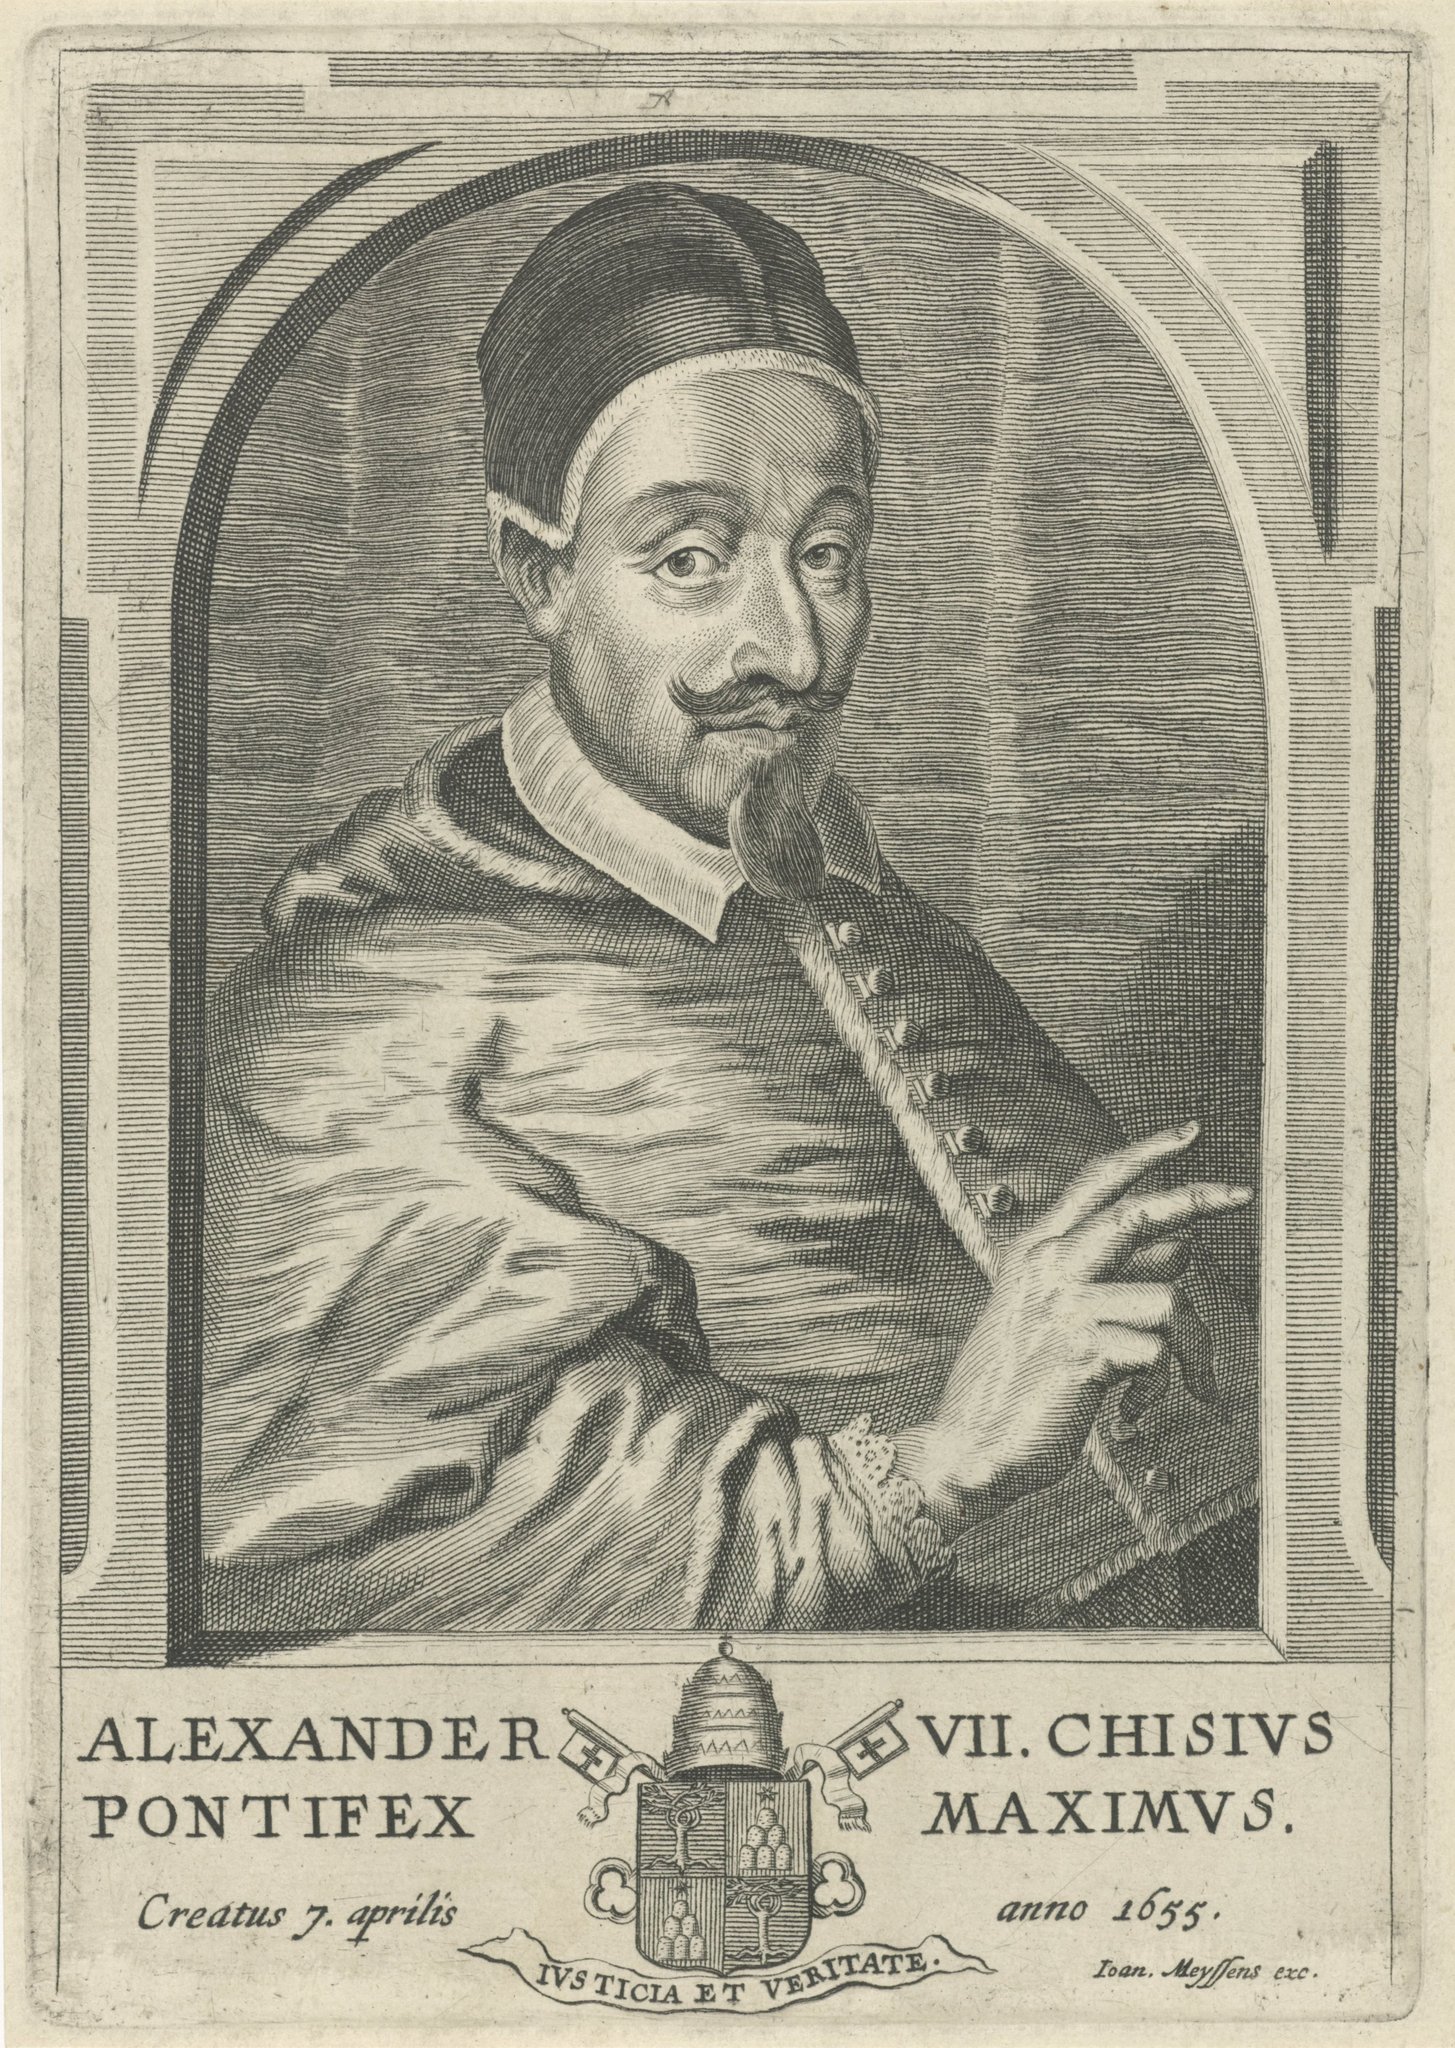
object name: print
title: Portret van paus Alexander VII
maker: joannes meyssens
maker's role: print maker, publisher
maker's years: 1612-1670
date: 1655-1657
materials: paper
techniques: engraving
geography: antwerp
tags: rome, alexander vii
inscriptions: collector's mark: Lugt 2228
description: Portret van paus Alexander VII, het hoofd getooid met een camauro, op 7 april 1655 tot paus benoemd. Midden onder in de marge zijn pauselijk wapen.